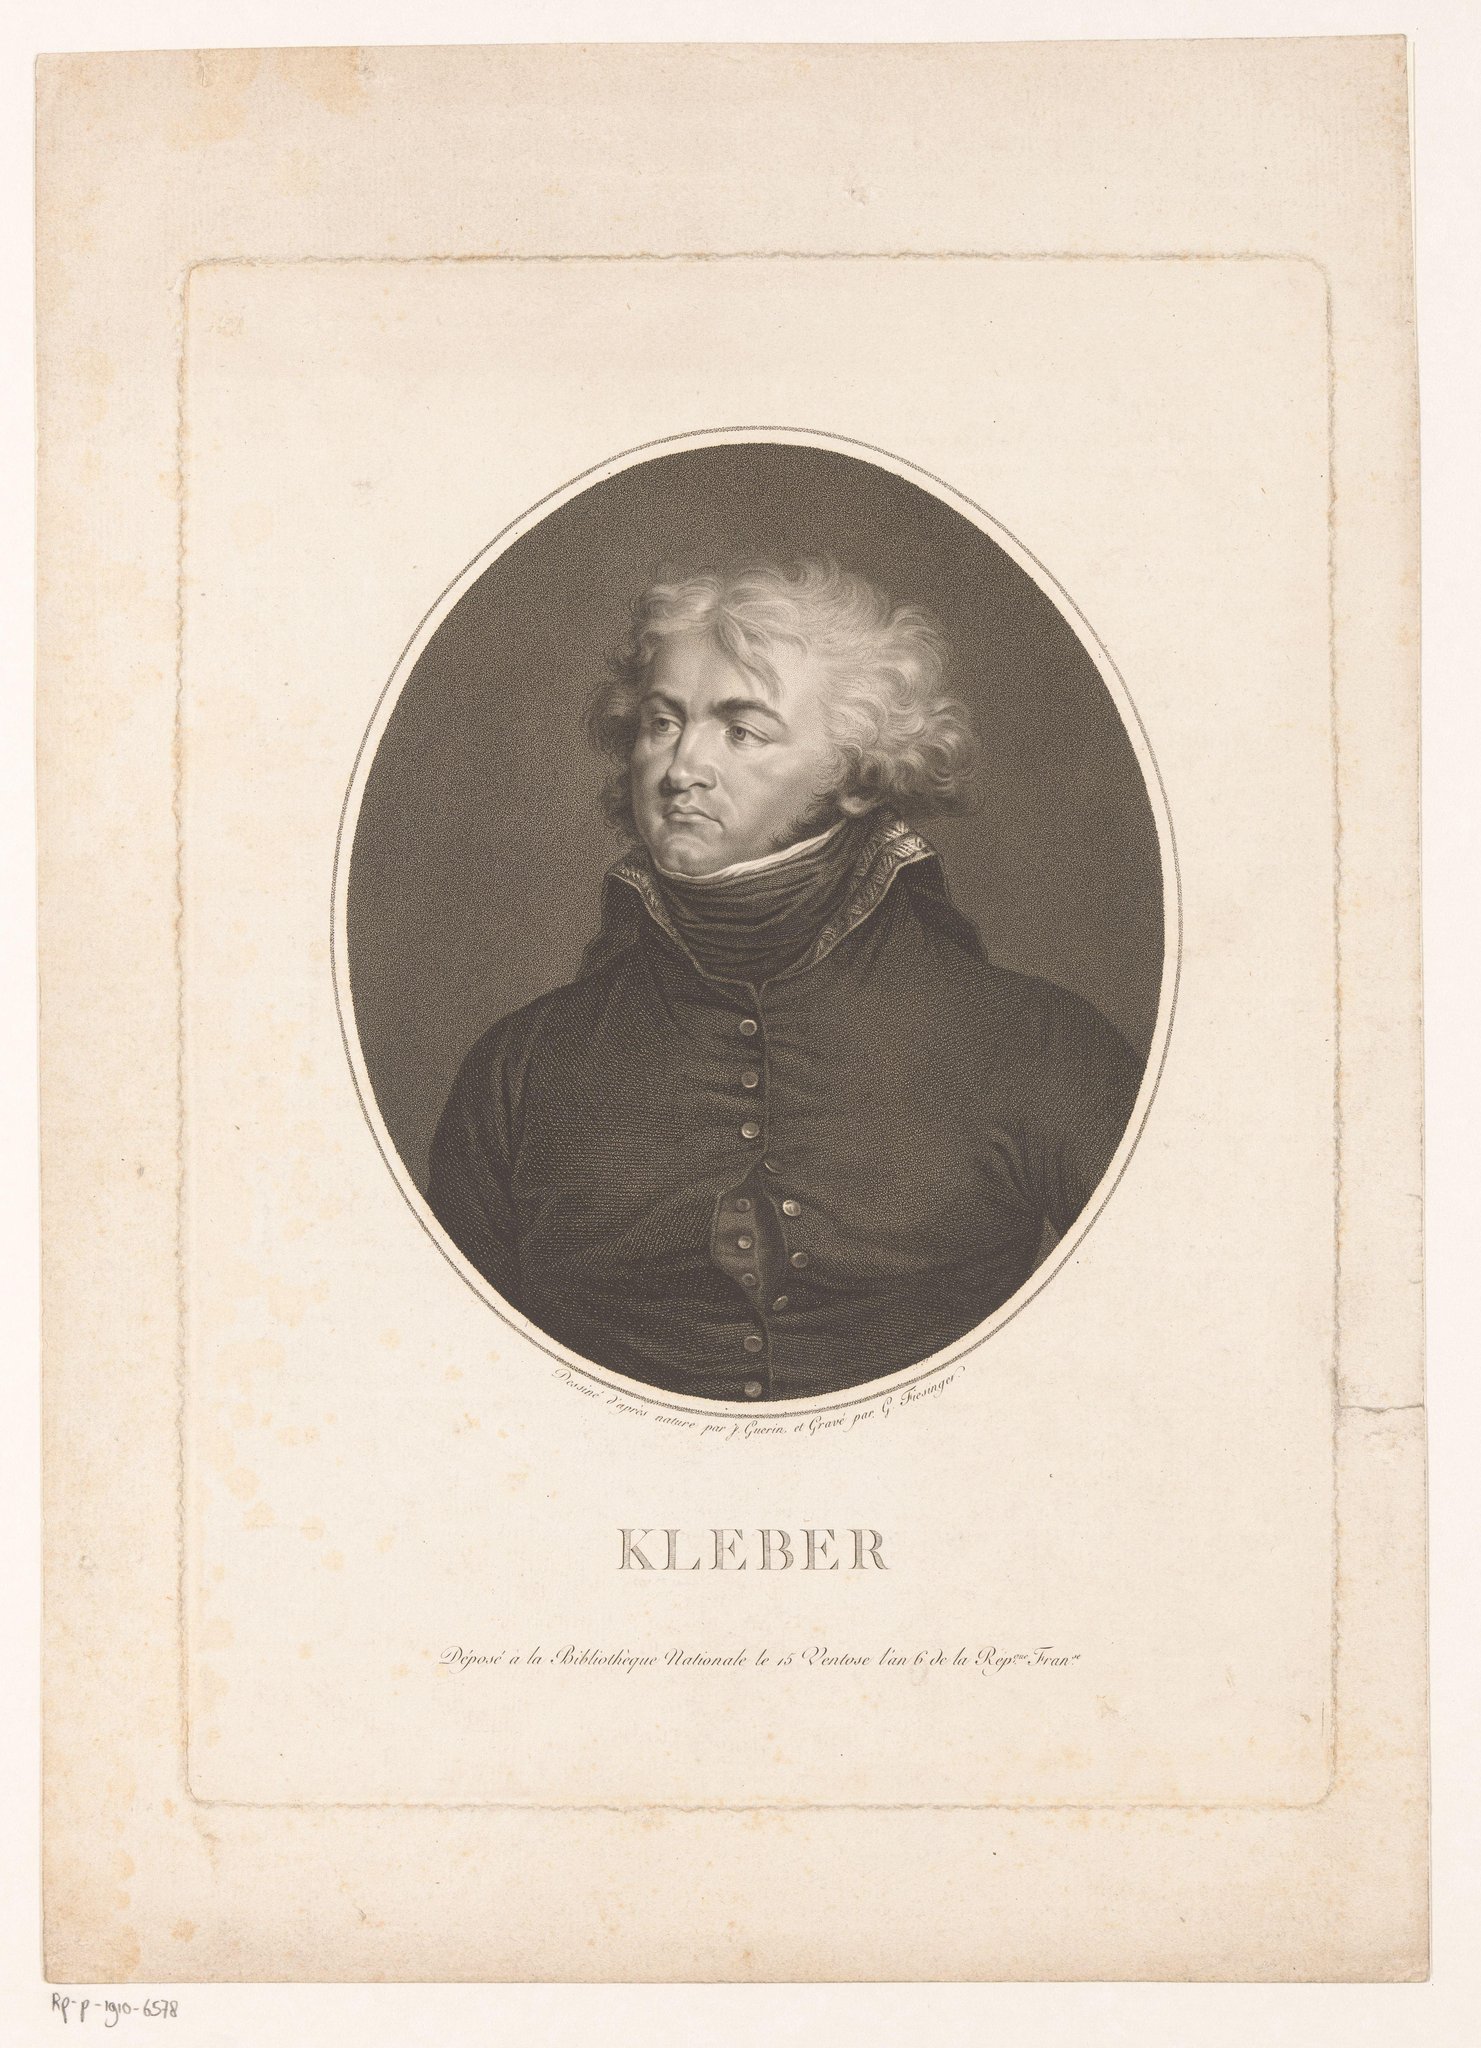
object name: print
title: Portret van Jean-Baptiste Kléber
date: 1770-1807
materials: paper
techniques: engraving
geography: france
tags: historical persons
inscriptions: collector's mark: Lugt 2228